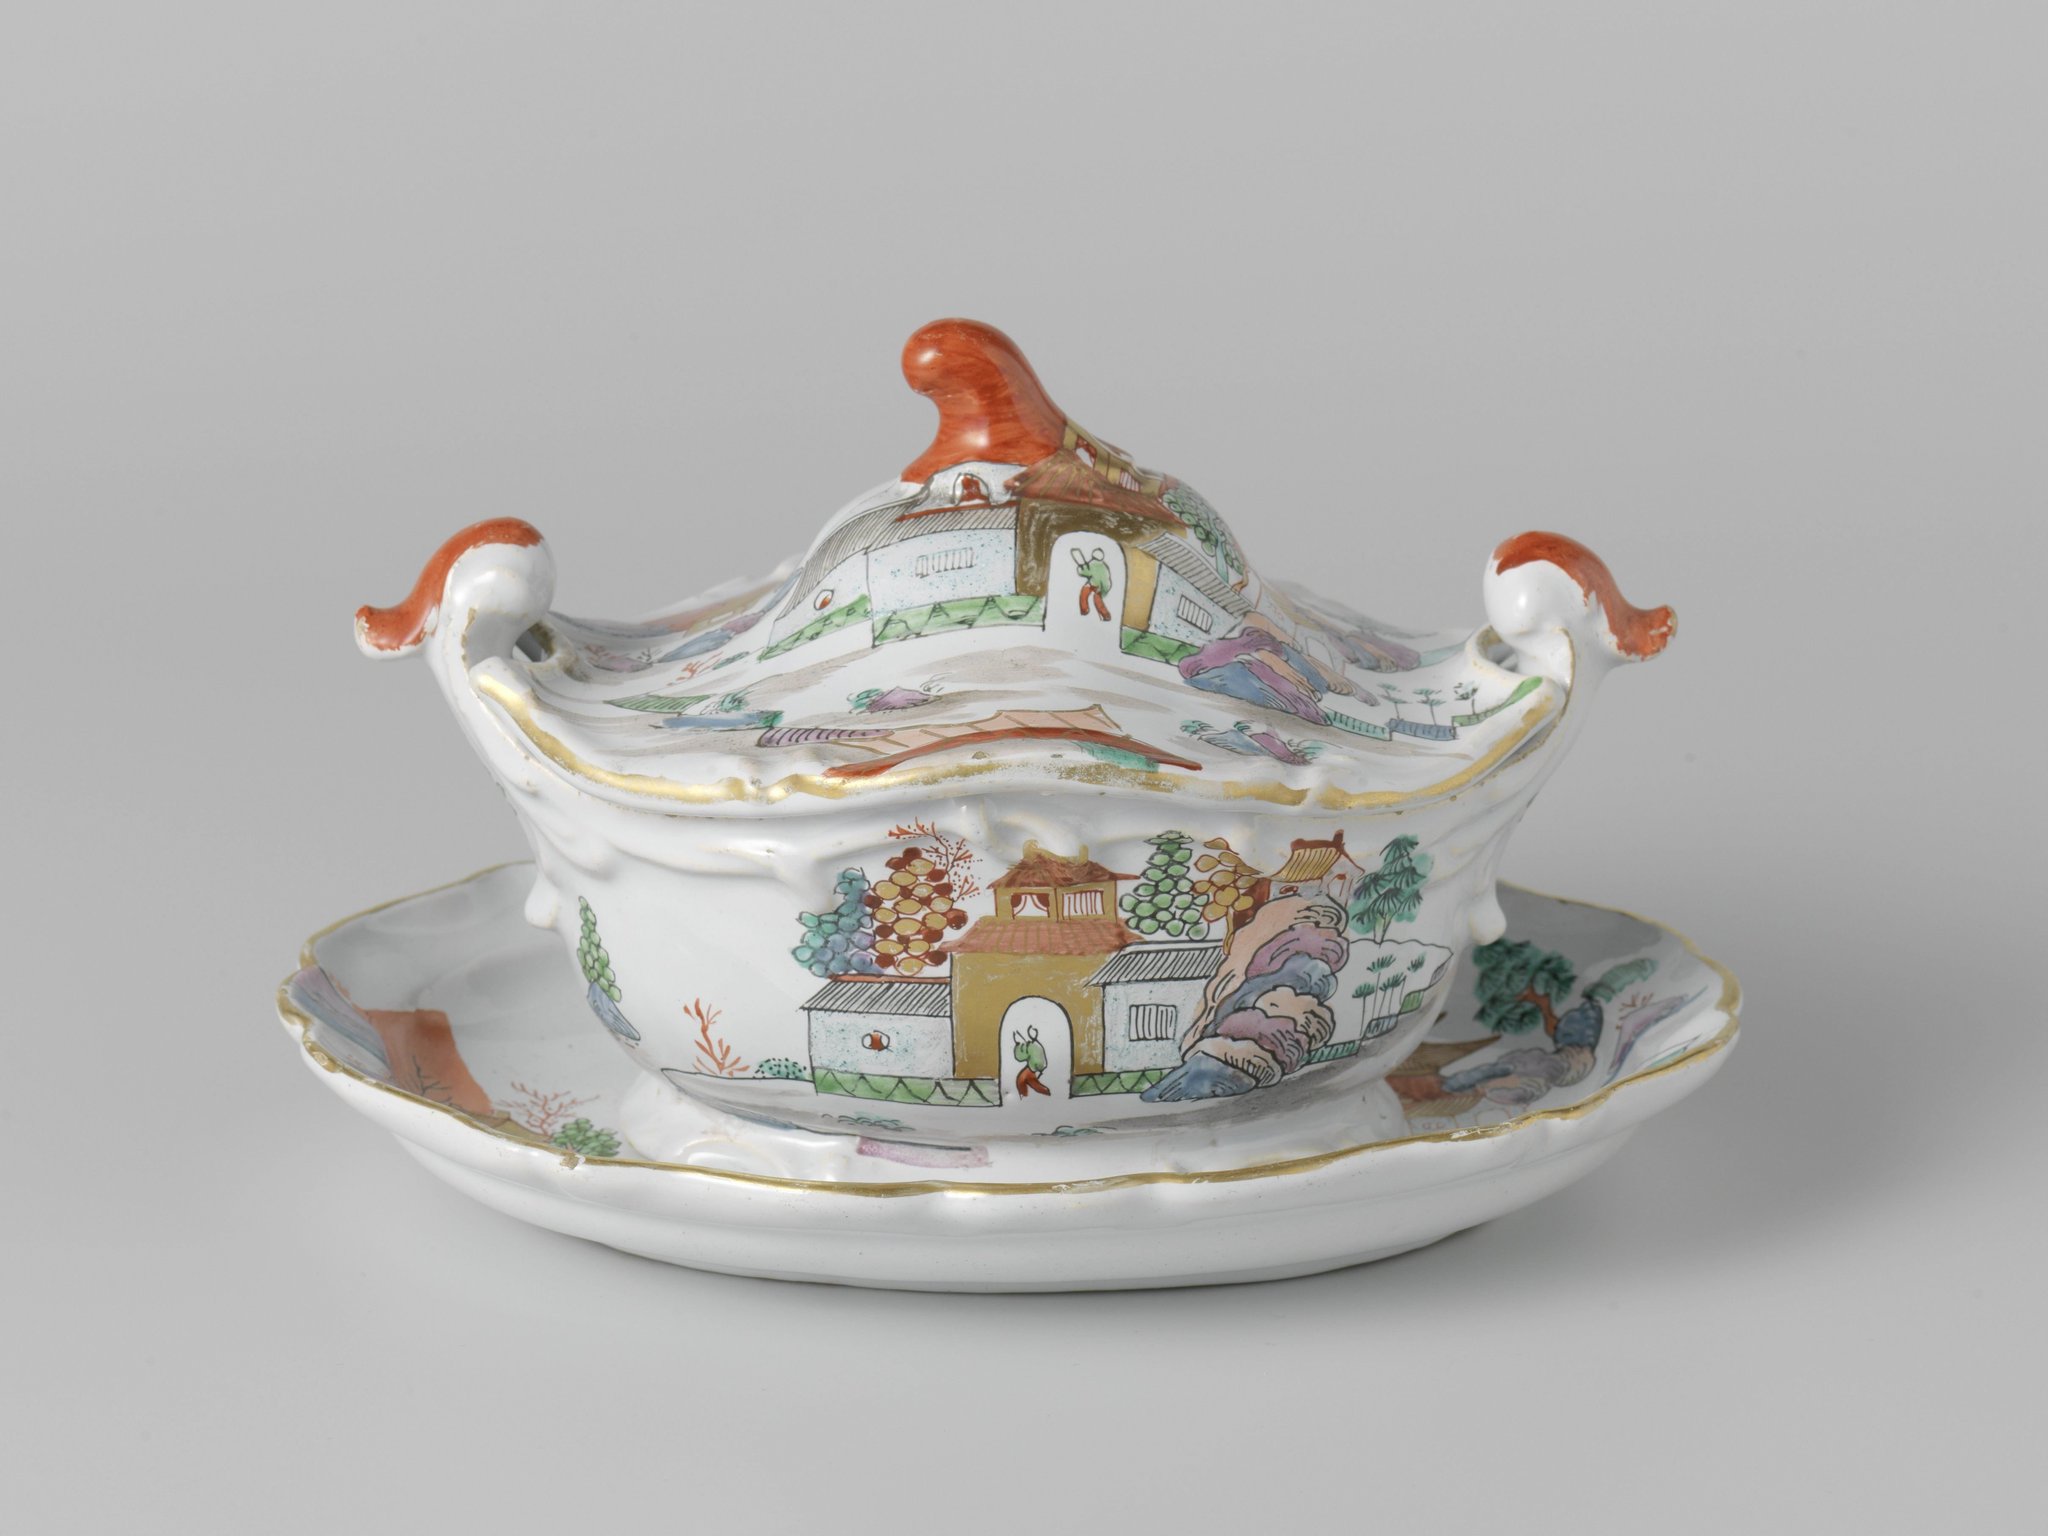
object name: butter dish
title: Botervloot, beschilderd met oosters landschap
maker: jacobus adriaens halder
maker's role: fayencier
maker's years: 1741-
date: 1765-1768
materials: faience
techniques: kiln, painted, polychromy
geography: delft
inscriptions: mark: ‘A/ IH’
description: Botervloot. Met bijbehorende deksel (B) en onderschotel (A) veelkleurig versierd met een oosters landschap met rotsen en gebouwen. Gemerkt.